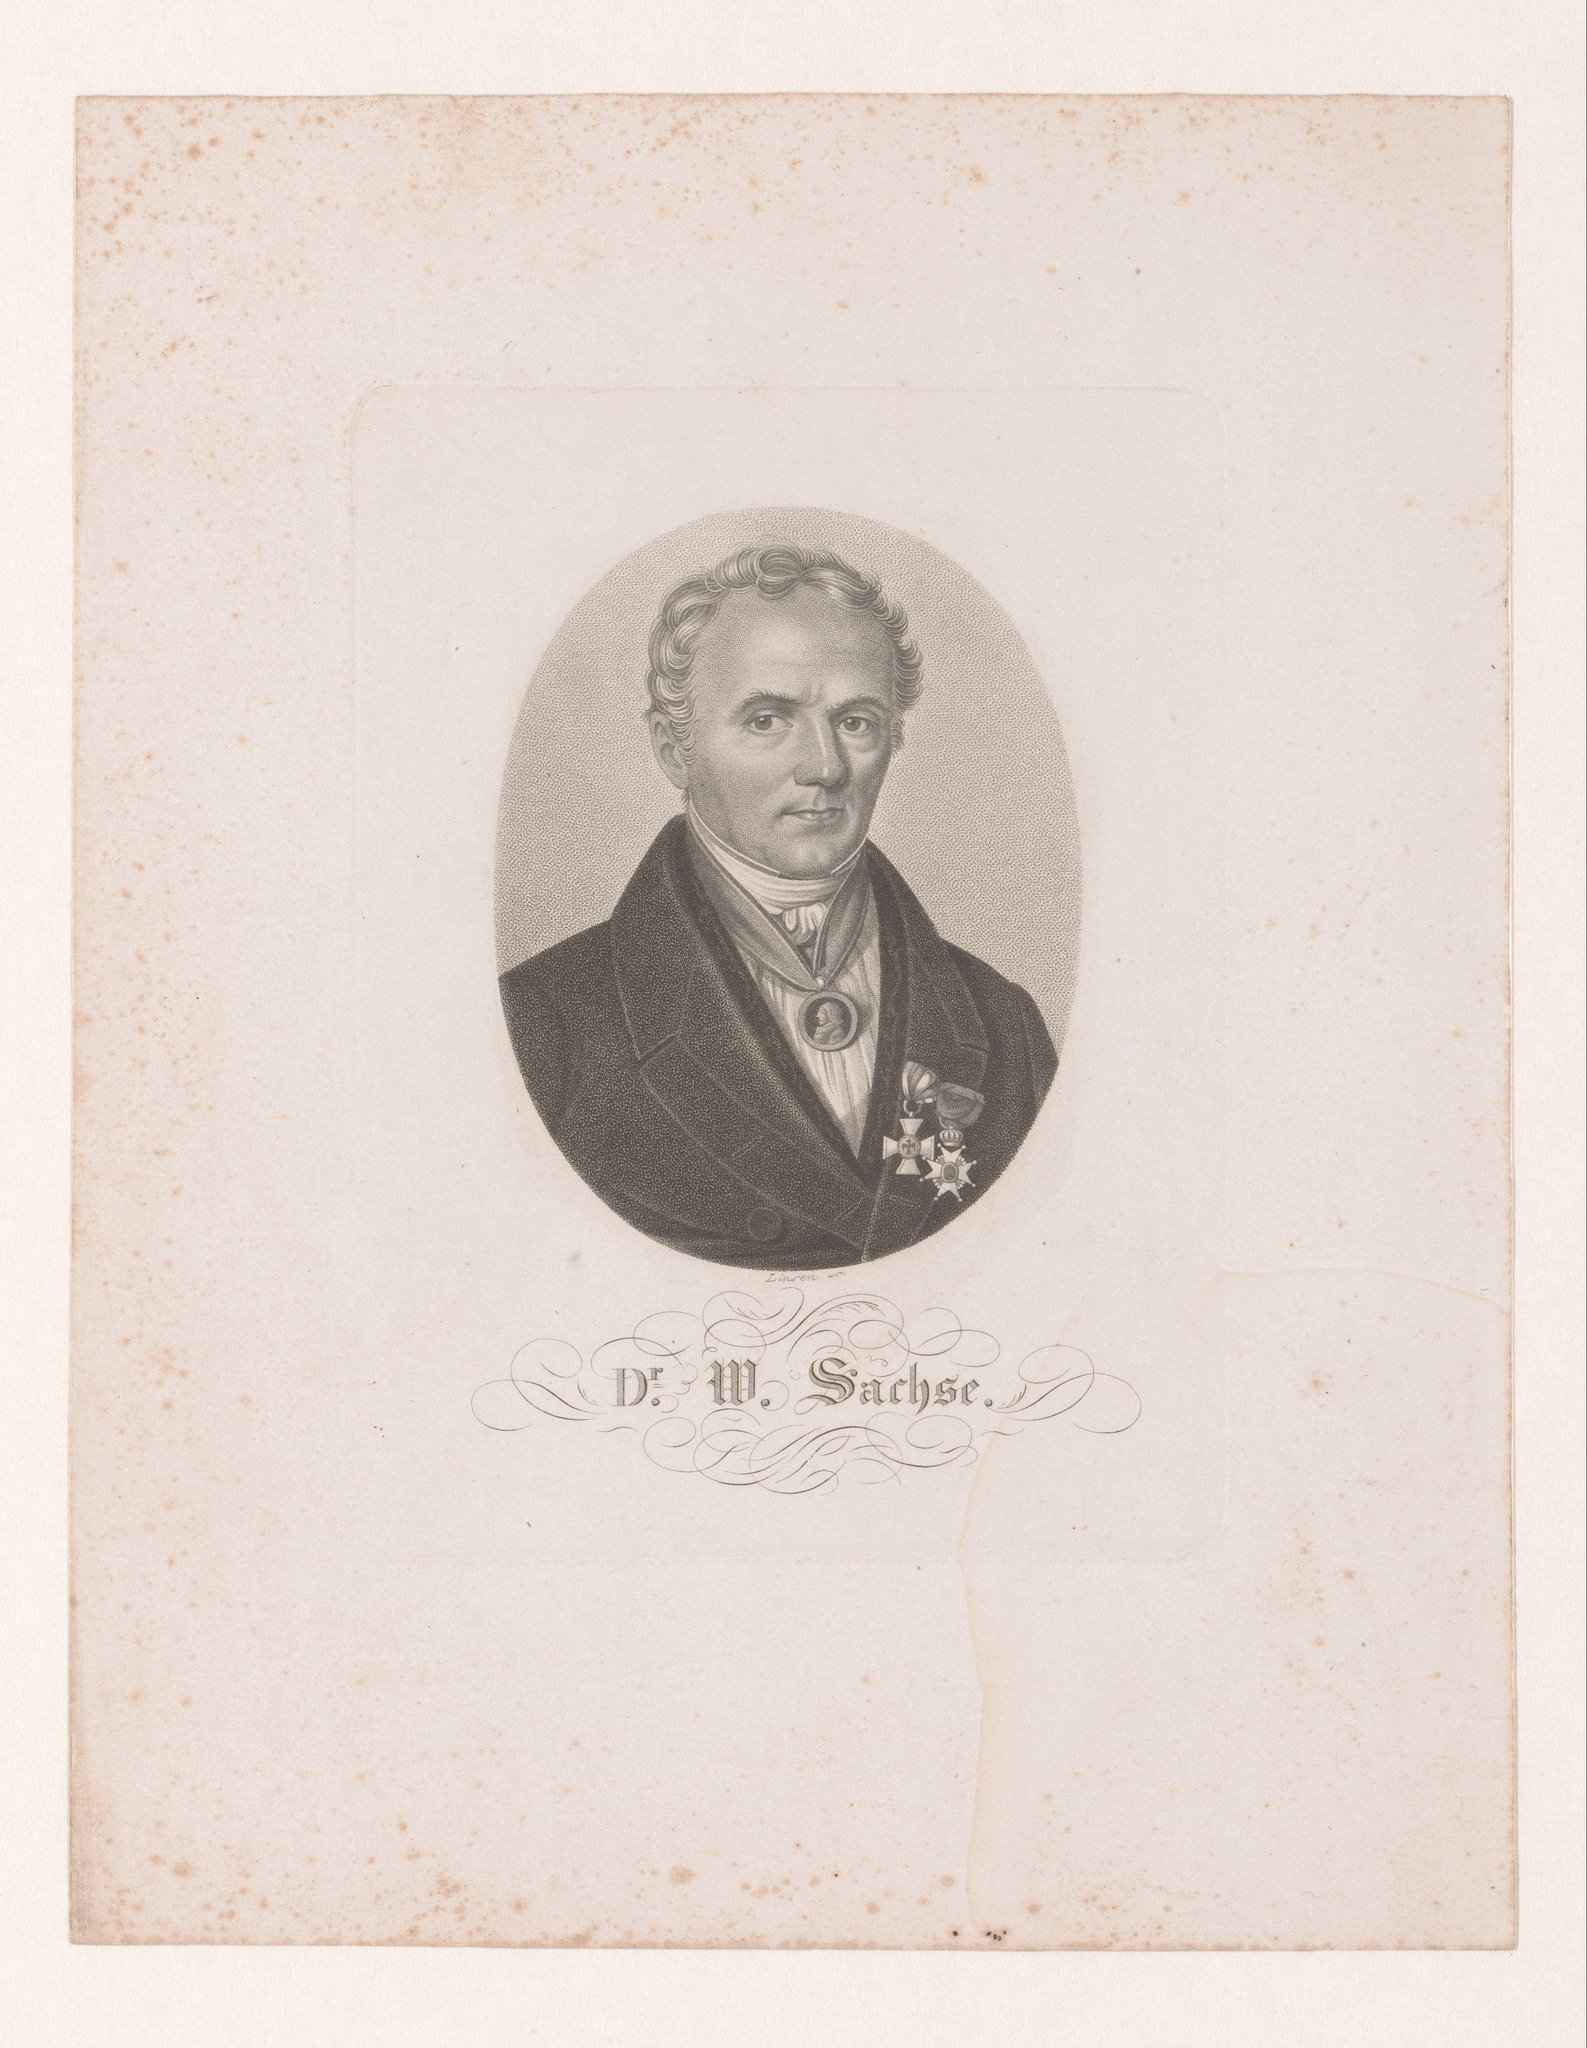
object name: print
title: Portret van Johann David Wilhelm Sachse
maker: l. linsen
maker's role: print maker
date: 1839-1856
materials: paper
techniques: stippling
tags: historical persons, physician, doctor (+ portrait of scholar, scientist)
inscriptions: collector's mark: Lugt 2228